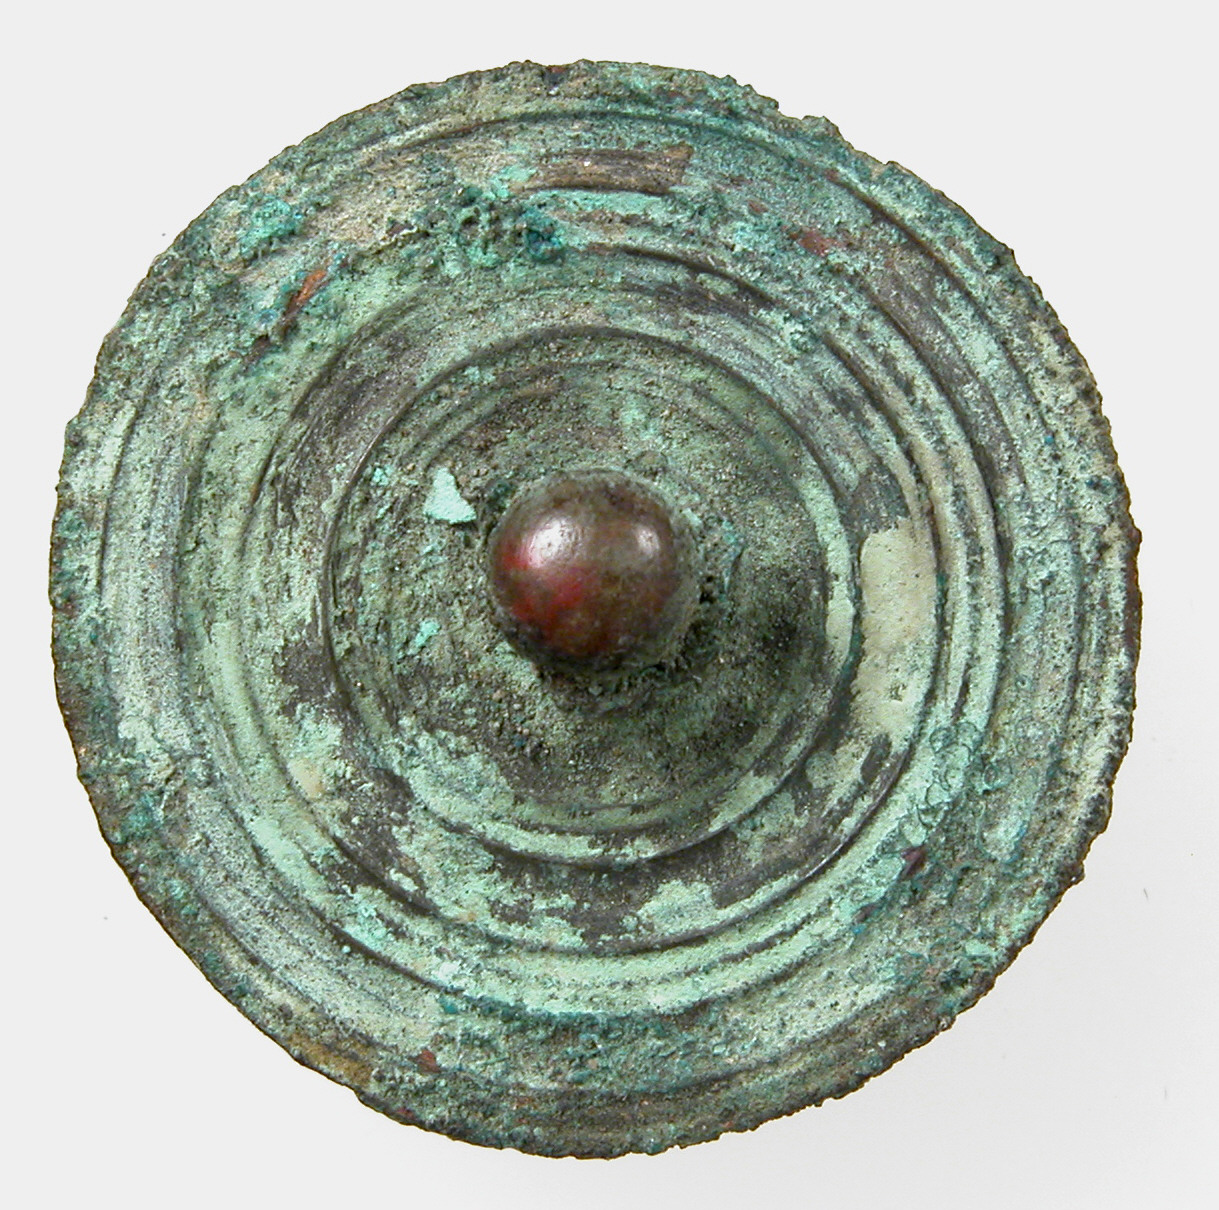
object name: brooch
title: Disk Brooch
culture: roman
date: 1-400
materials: copper alloy